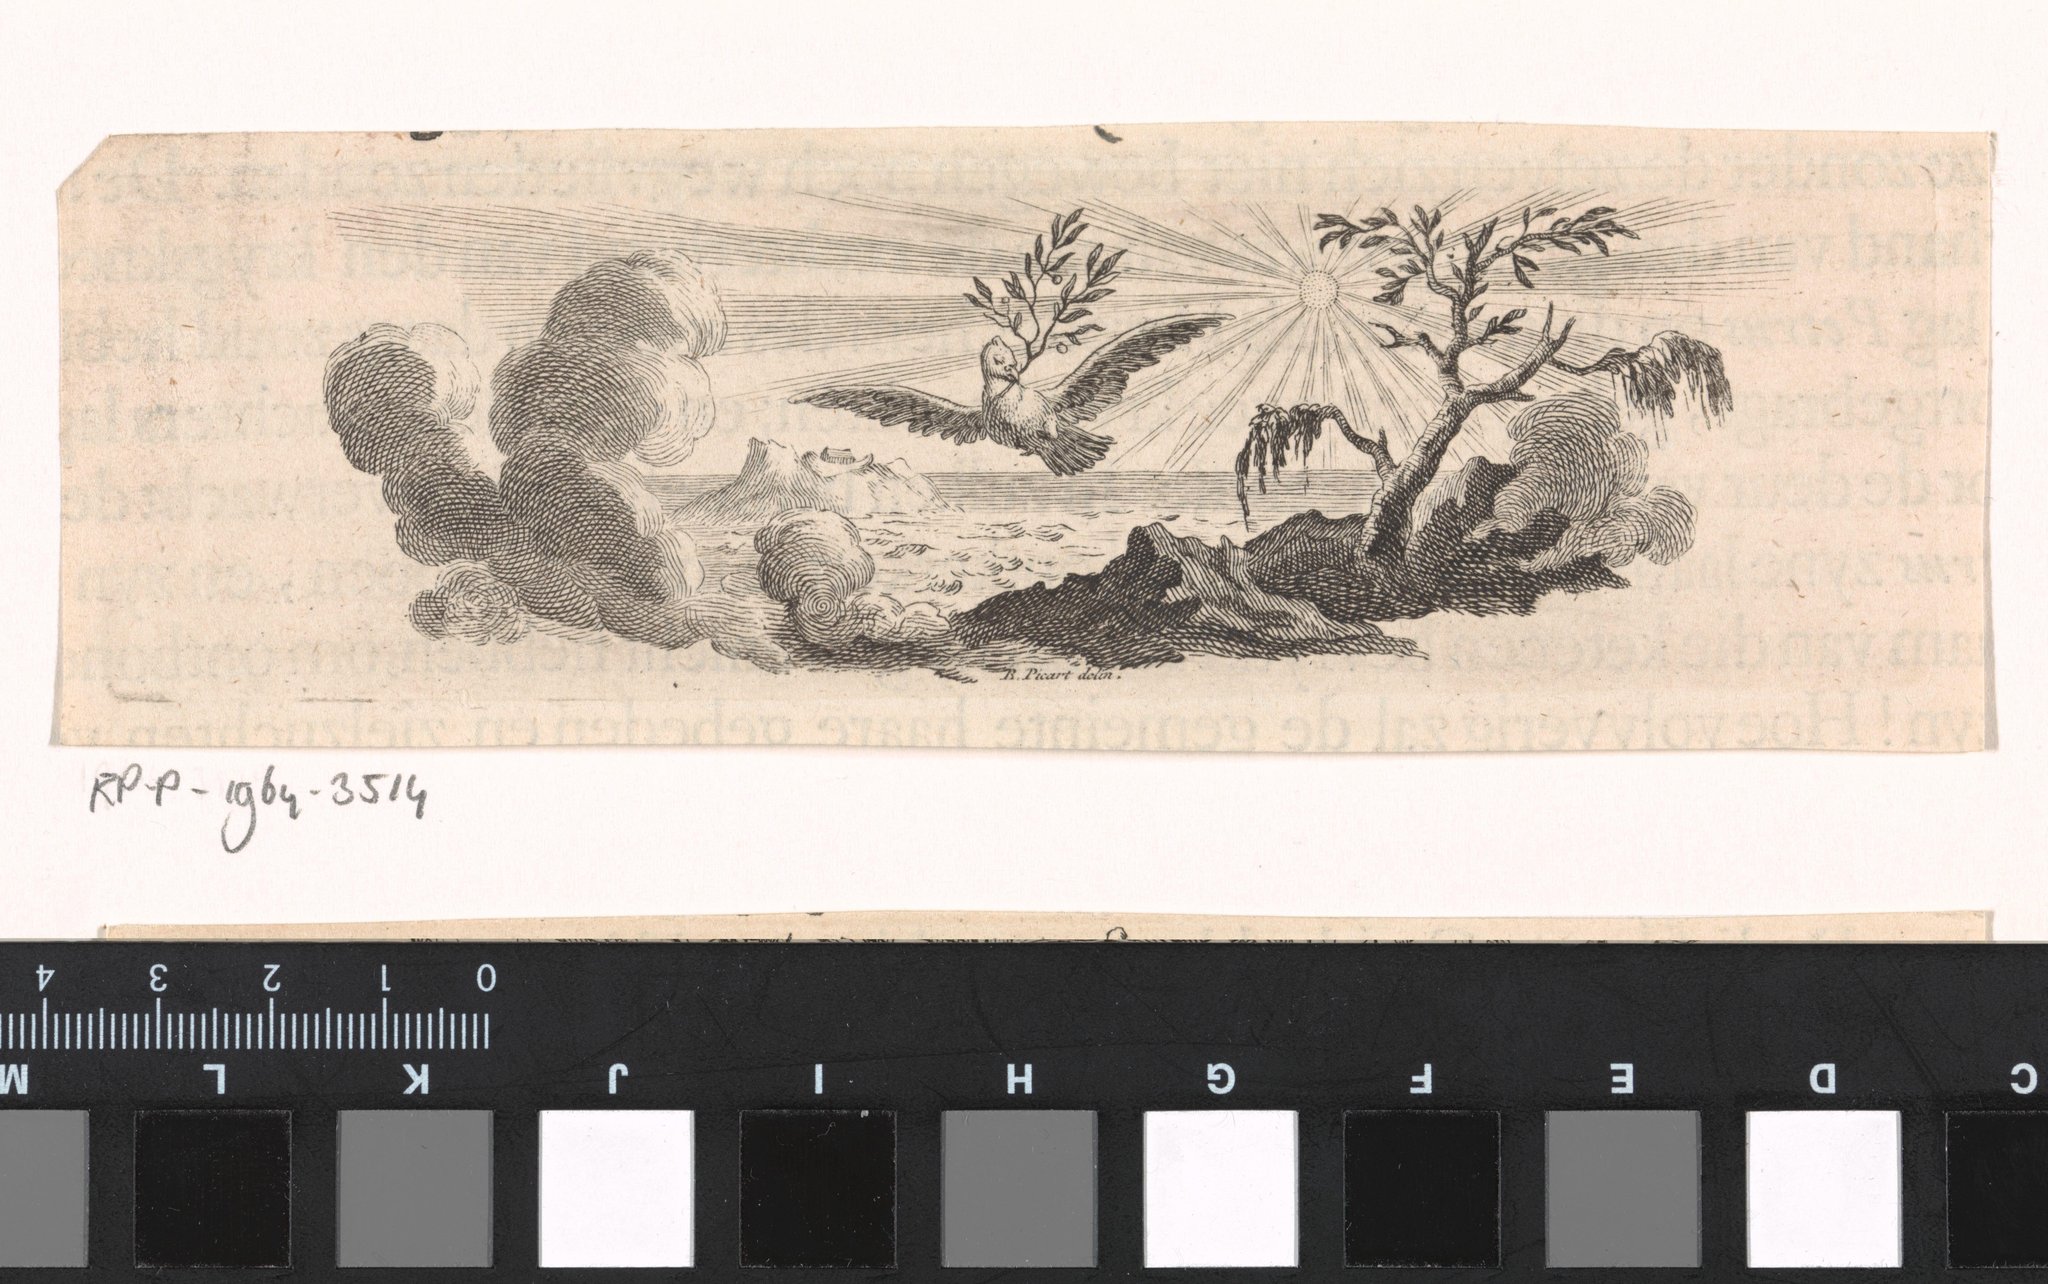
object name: book illustration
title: Duif keert terug met olijftak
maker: bernard picart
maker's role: draughtsman, print maker, publisher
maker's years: 1673-1733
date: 1683-1733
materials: paper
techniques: engraving, etching, letterpress printing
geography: amsterdam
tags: the dove returns with an olive-branch ~ story of noah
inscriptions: collector's mark: Lugt 2228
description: Prent oorspronkelijk bedoeld voor: Figures de la Bible. Amsterdam, Bernard Picart, 1720. Prent ook gebruikt in: Taferelen der voornaamste geschiedenissen van het Oude en Nieuwe Testament (...) door de vermaarde kunstenaars Hoet, Houbraken, en Picart getekent (...) en met beschrijvingen uitgebreid. Den Haag: Pieter de Hondt, 1728. Prent kan mogelijk ook zijn gebruikt in andere bijbels.